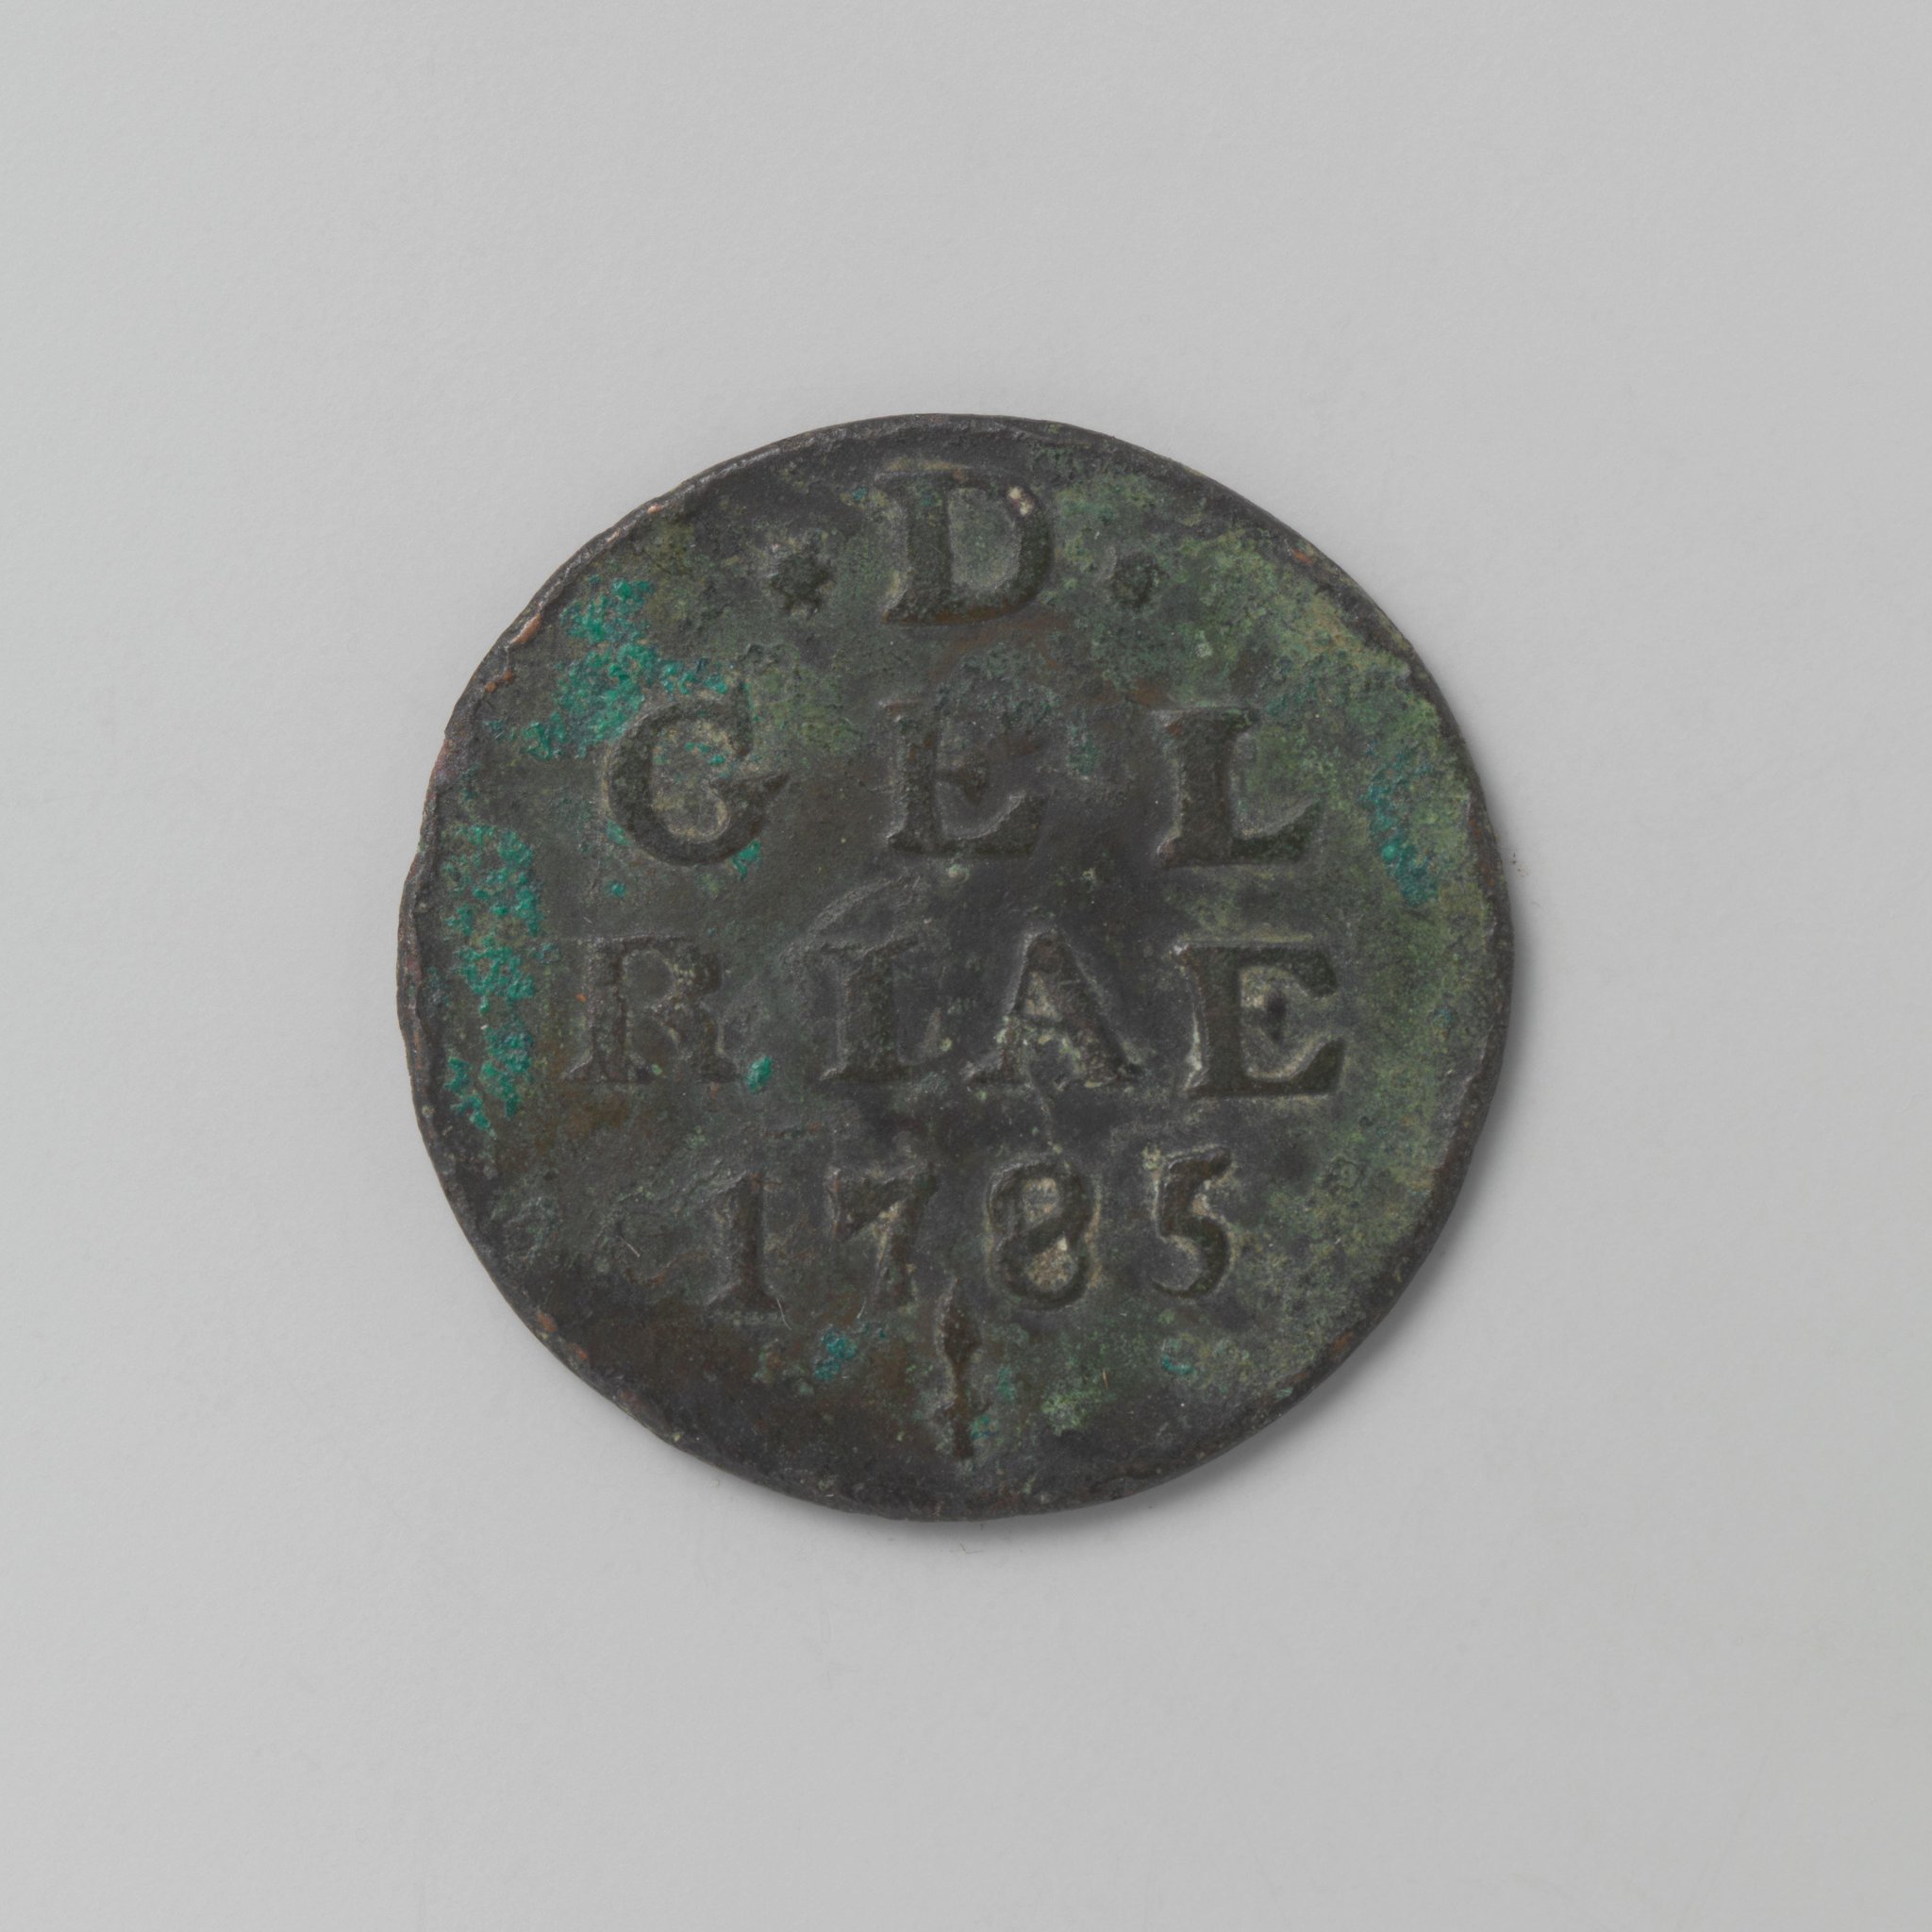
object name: coin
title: Gelderse duit, 1785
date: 1785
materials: copper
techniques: striking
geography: harderwijk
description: Koperen munt. Voorzijde: in drie regels D/GEL/RIAE, daaronder jaartal en muntmeesterteken. Keerzijde: gekroond Gelders wapenschild.